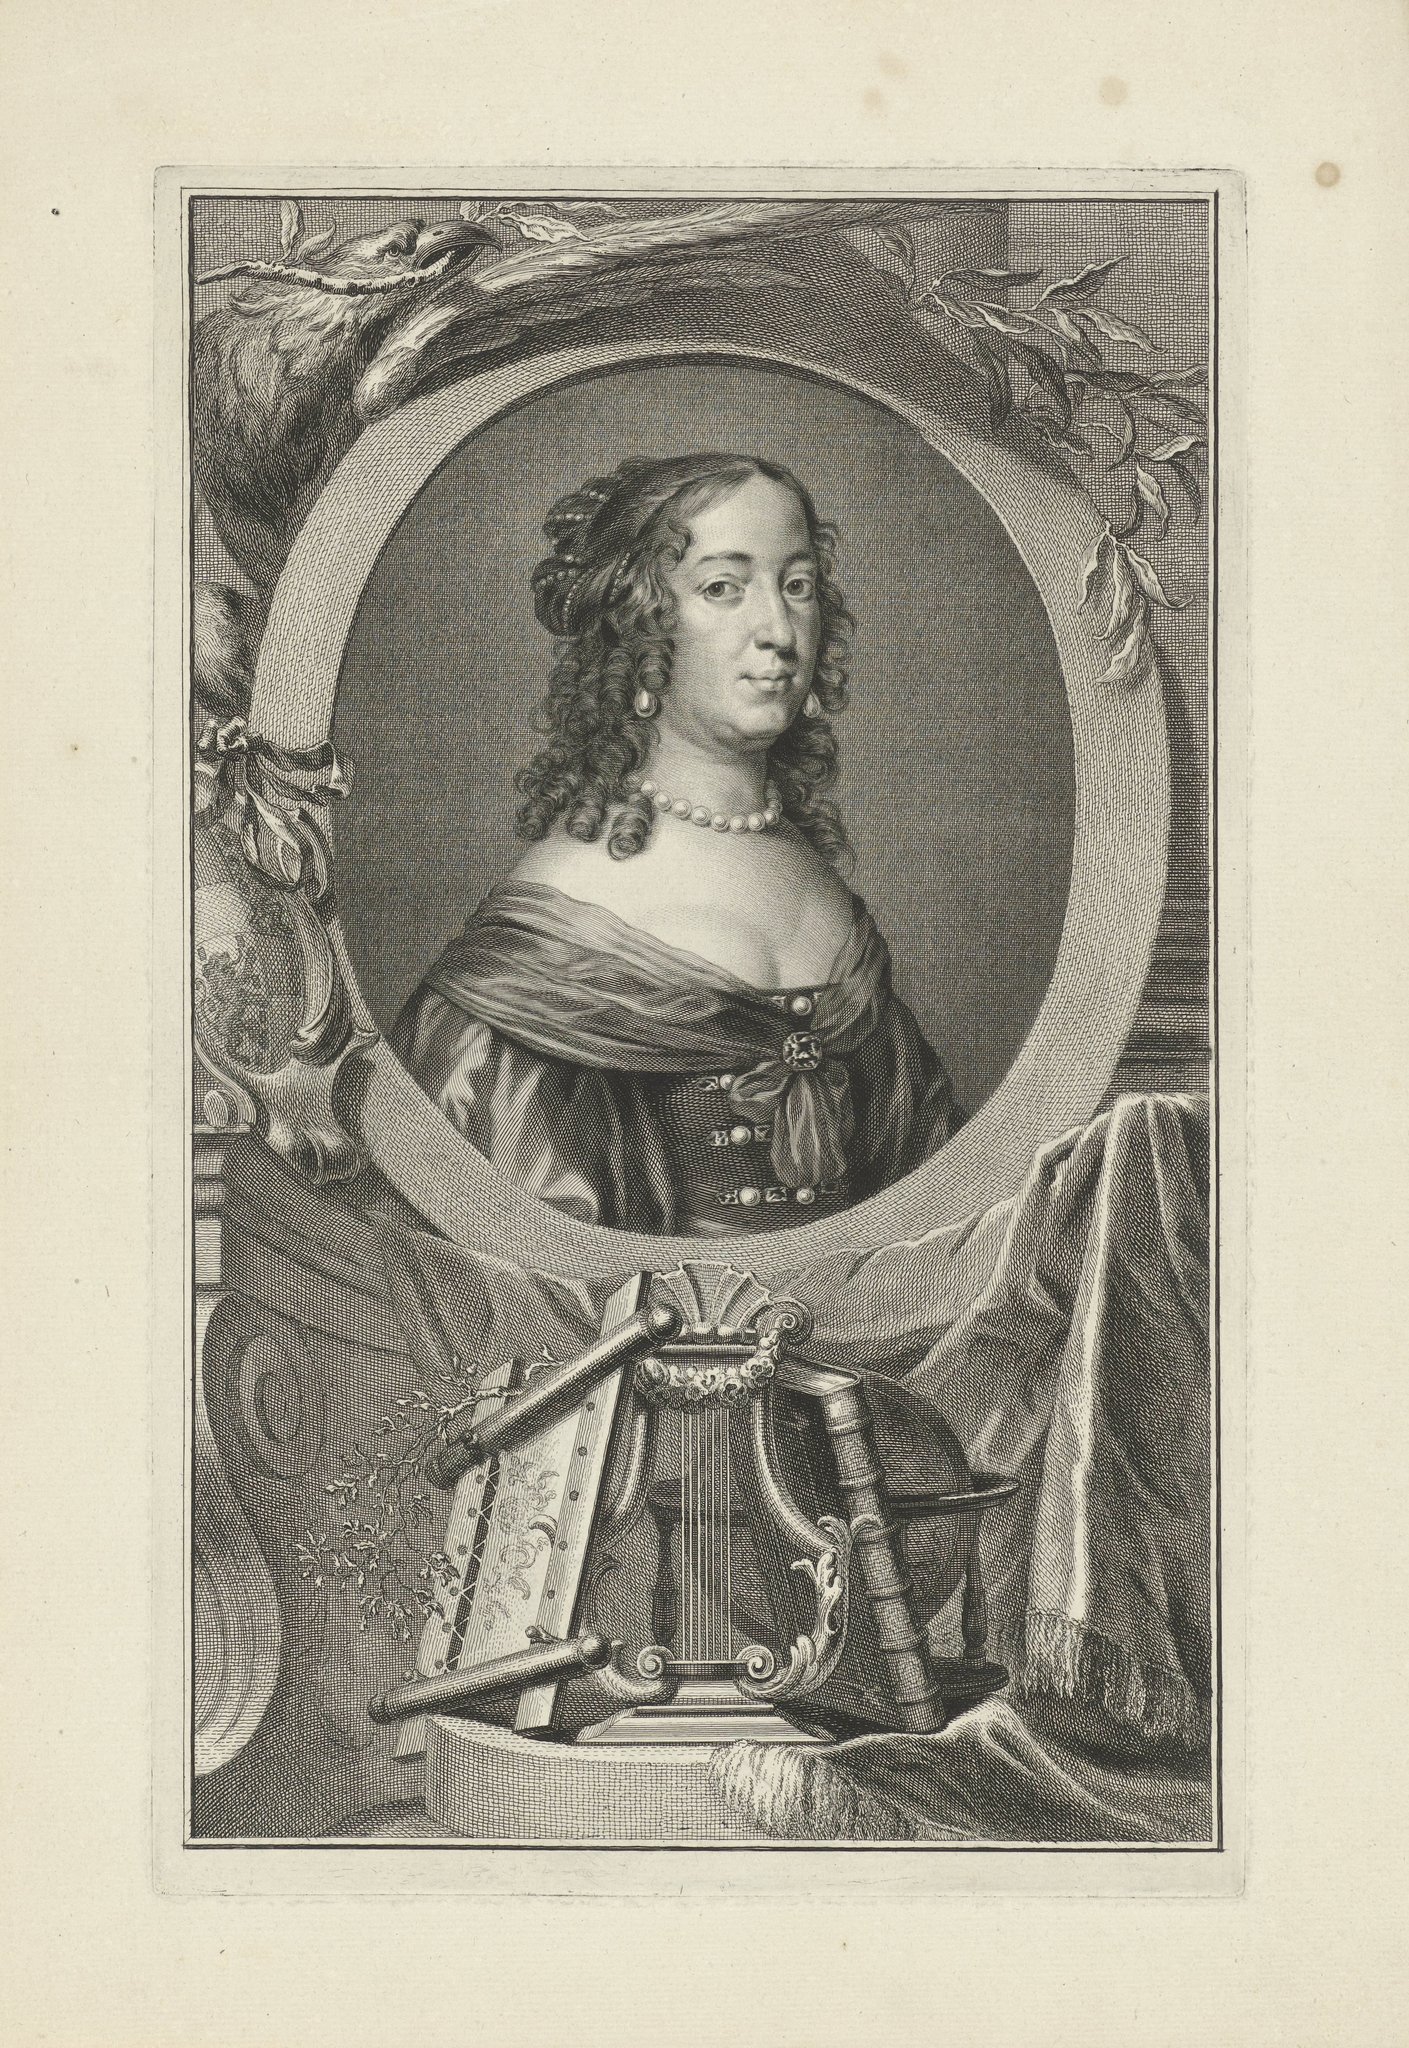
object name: print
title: Gemalinnen en moeders der stadhouderen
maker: jacob houbraken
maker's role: draughtsman, print maker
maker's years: 1698-1780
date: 1751-1753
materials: paper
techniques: engraving, etching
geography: amsterdam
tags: the hague, amalia of solms-braunfels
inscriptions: collector's mark: Lugt 2228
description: Portret van Amalia van Solms, echtgenote van Frederik hendrik. Vierde prent uit een serie van zes met de afbeeldingen van de gemalinnen en moeders van de stadhouders.